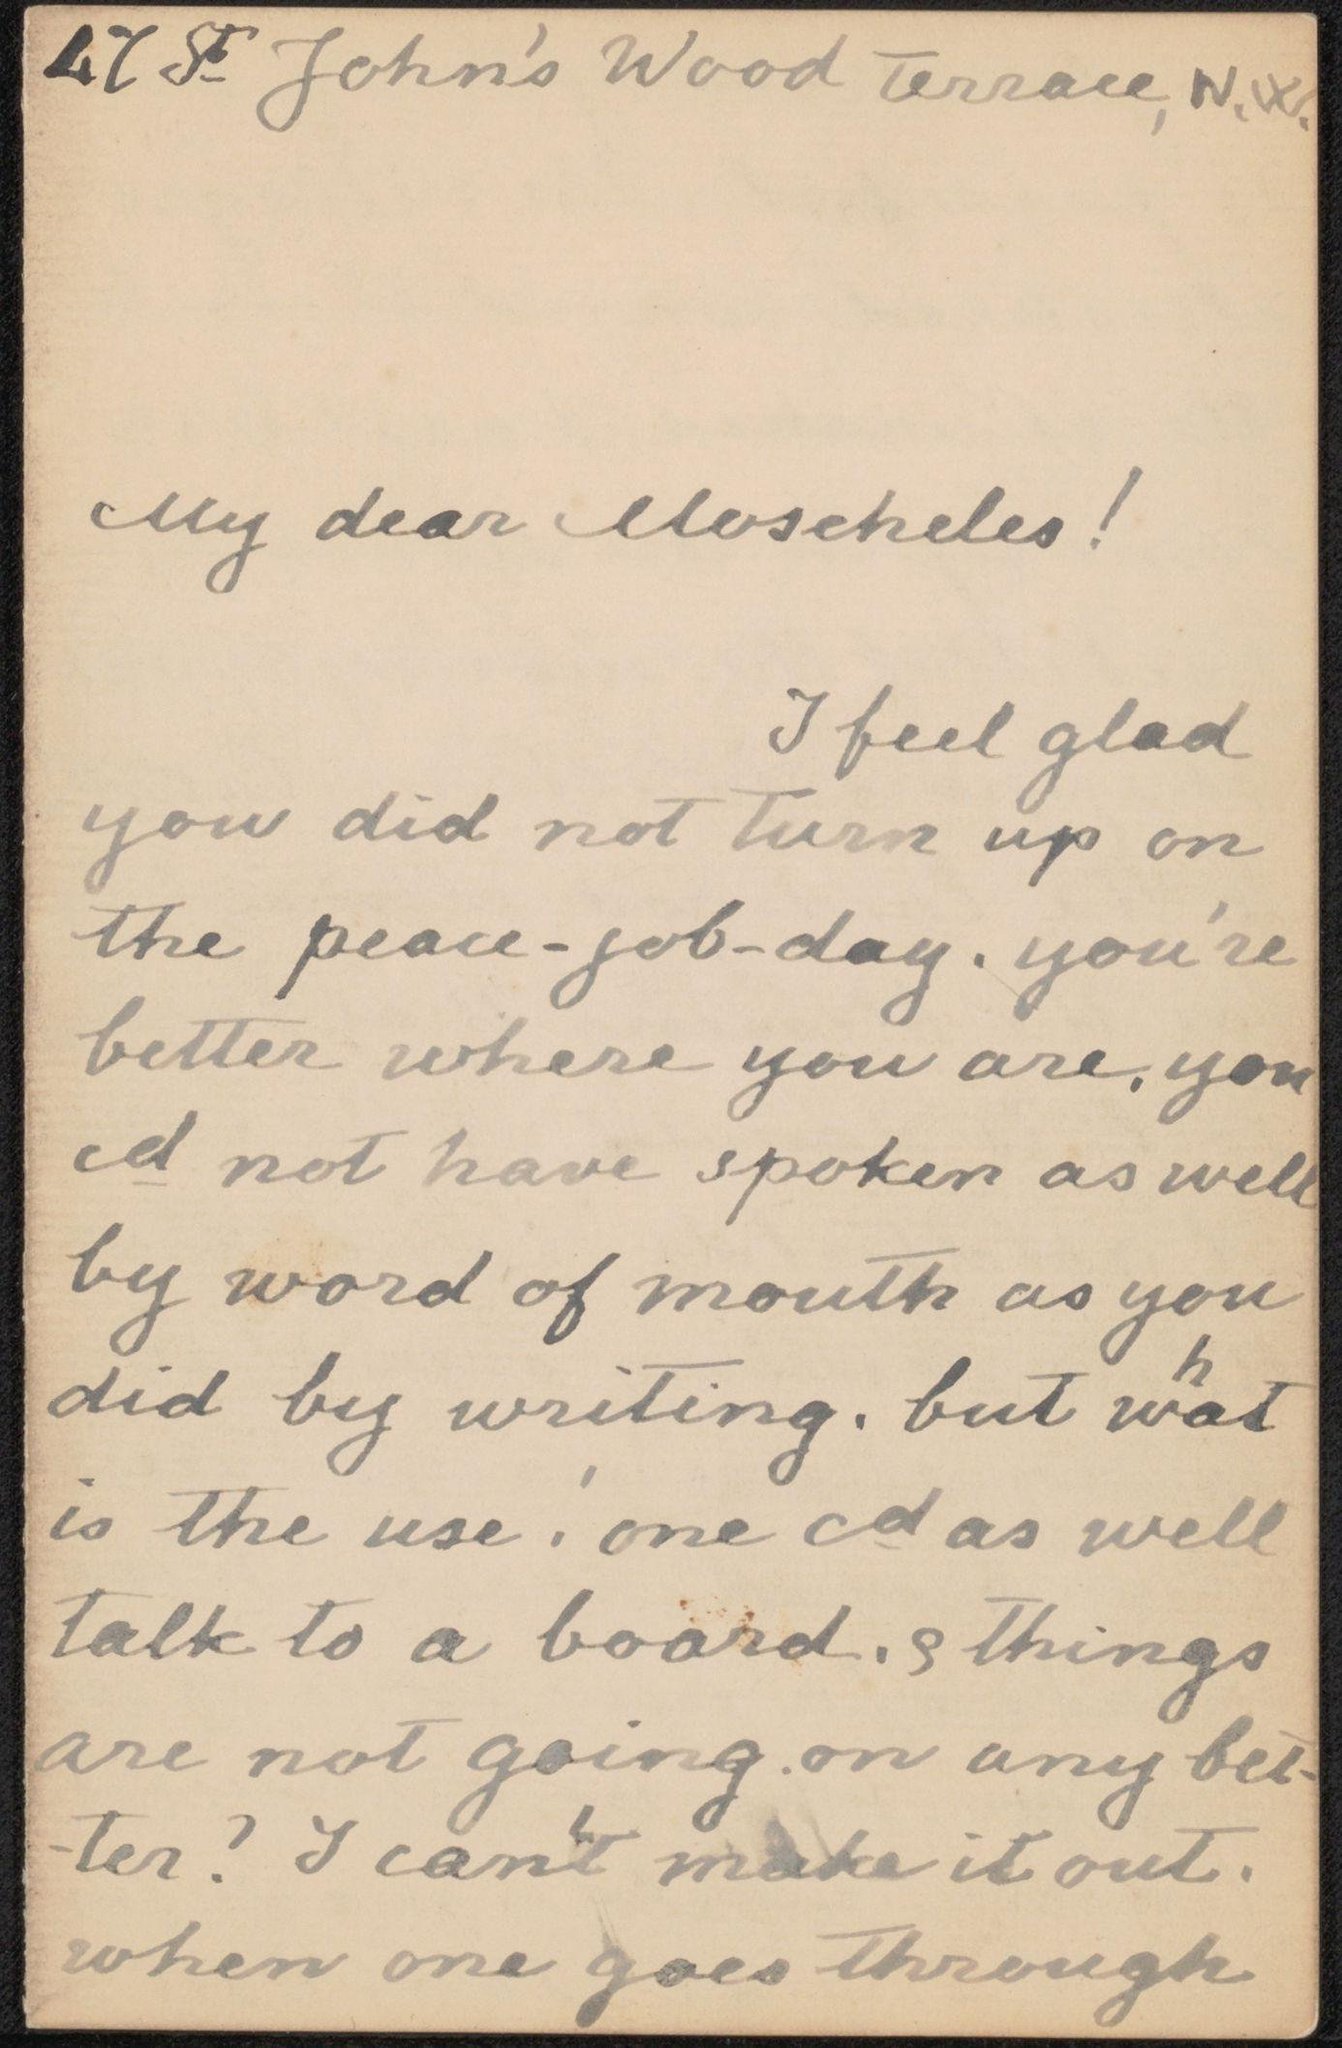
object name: letter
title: Brief aan Felix Stone Moscheles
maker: matthijs maris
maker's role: draughtsman, painter, print maker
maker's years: 1839-1917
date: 1888-1906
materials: ink, paper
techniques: pen, writing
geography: london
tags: london, painter, non-christian religions (including institutions, customs and antiquities), christian religion, money, england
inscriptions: watermark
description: Brief bevat zes opgeplakte krantenknipsels.